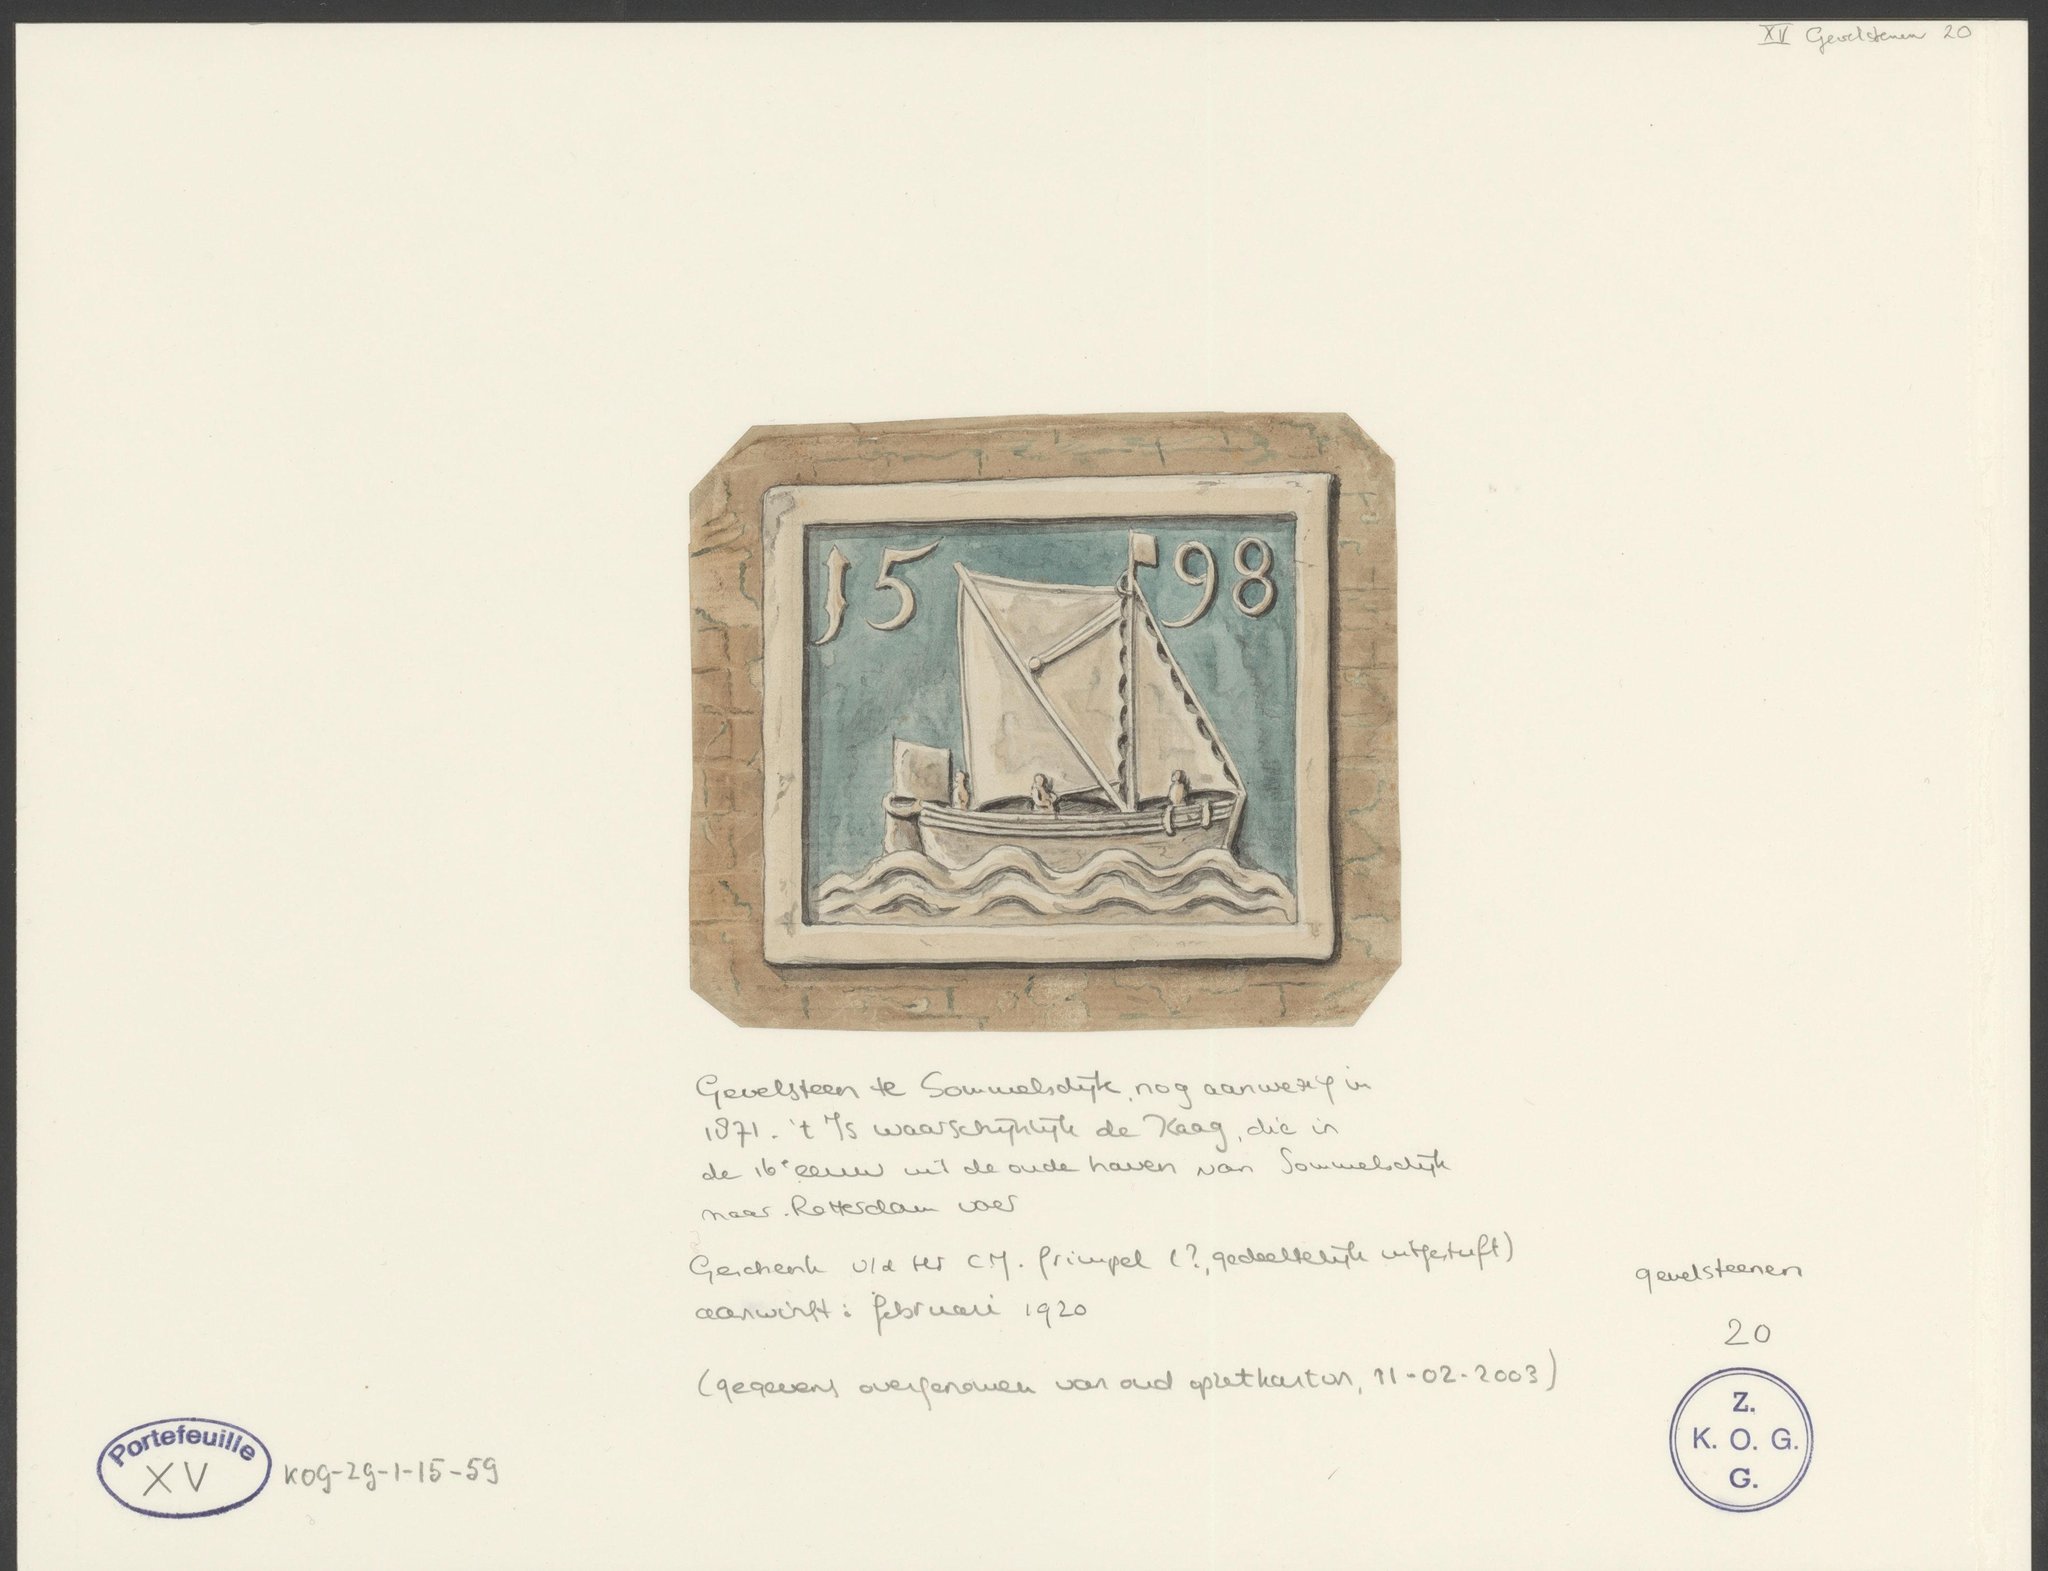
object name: drawing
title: Gevelsteen met zeilboot uit 1598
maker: Anonymous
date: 1750-1871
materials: paper, watercolor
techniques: brush, pen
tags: sailing-ship, sailing-boat, stone tablet in façade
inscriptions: collector's mark: Lugt 1641, stamp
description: Onderwerpsrubrieken binnen de Atlas Zeden en Gewoonten: Handel, nijverheid en verkeer, Uithangteekens, gevelstenen.